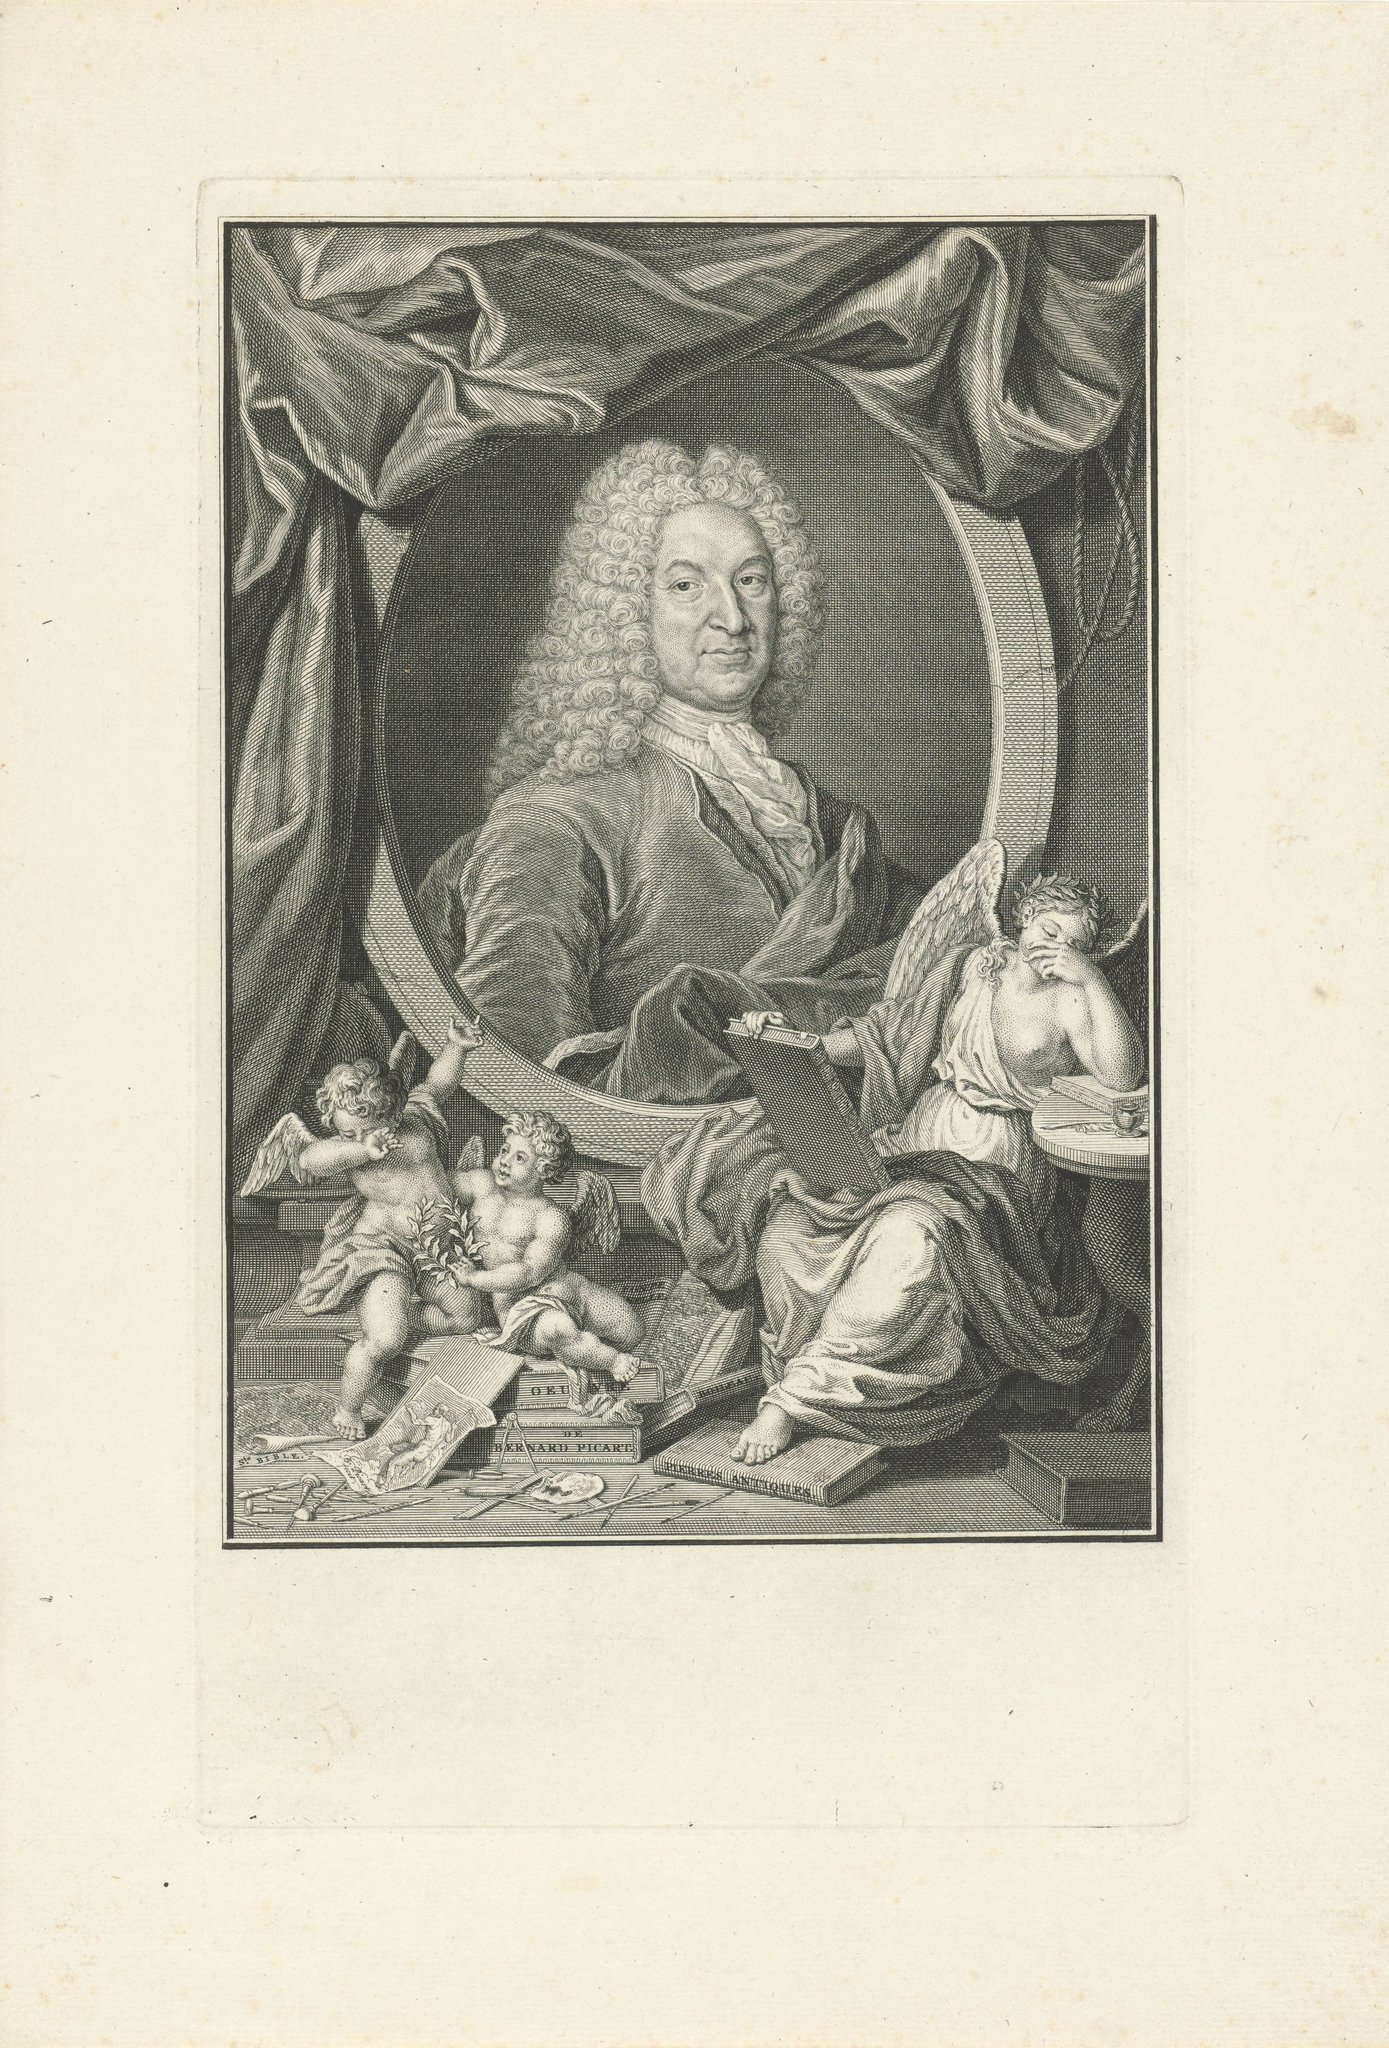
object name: print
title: Portret van Bernard Picart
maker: jacob van der schley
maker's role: draughtsman, print maker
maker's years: 1715-1779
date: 1734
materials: paper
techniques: engraving, etching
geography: amsterdam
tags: paris, amsterdam, print maker, draughtsman, publisher, bernard picart, tools, implements of craftsman (+ engraving, etching), historical persons, brushes ~ implements of painter, mourning the dead, cupids: 'amores', 'amoretti', 'putti'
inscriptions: collector's mark: Lugt 240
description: Portret van de graveur, tekenaar en schilder Bernard Picart. Voor het portret treuren twee putti en zit een personificatie van Geschiedenis. Op de grond liggen boeken, prenten en schilder- en graveergereedschap.